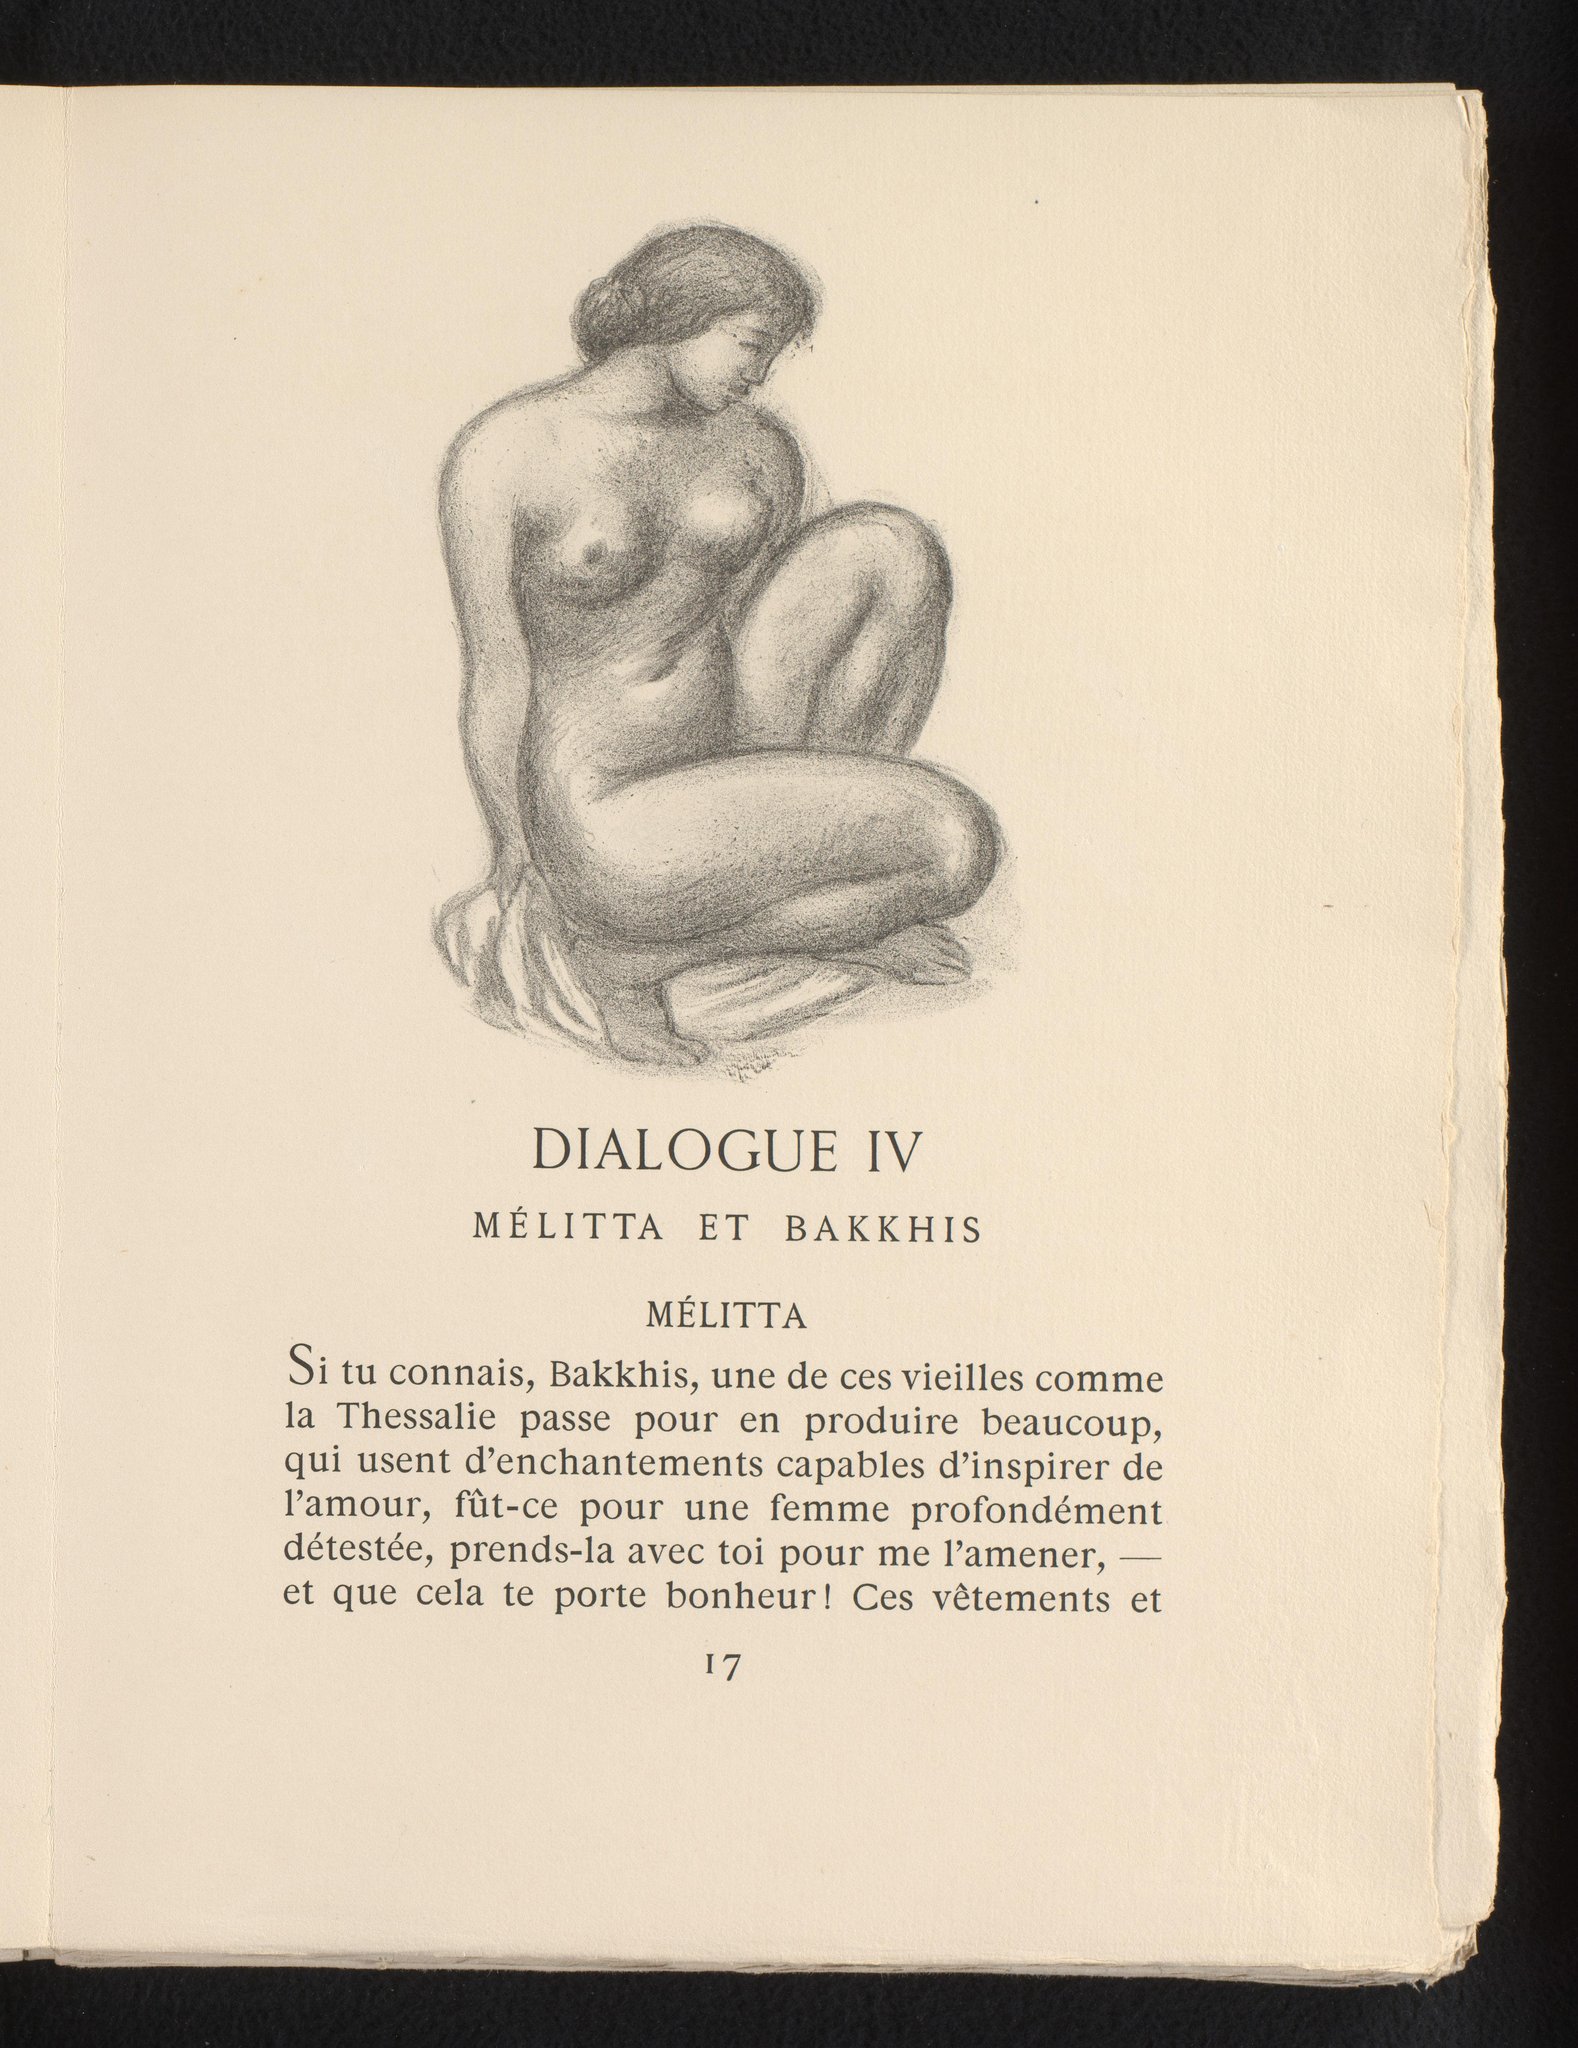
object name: book illustration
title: Knielende naakte vrouw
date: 1948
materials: paper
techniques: letterpress printing, lithograph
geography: paris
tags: kneeling figure - aa - female human figure, woman (showing herself) undressed, quasi-nude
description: Prent uit: Lucianus van Samosata. Dialogues des Courtisanes. [Vertaald uit het Grieks door] Charles Astruc. Parijs: s.n., 1948, p. 17.